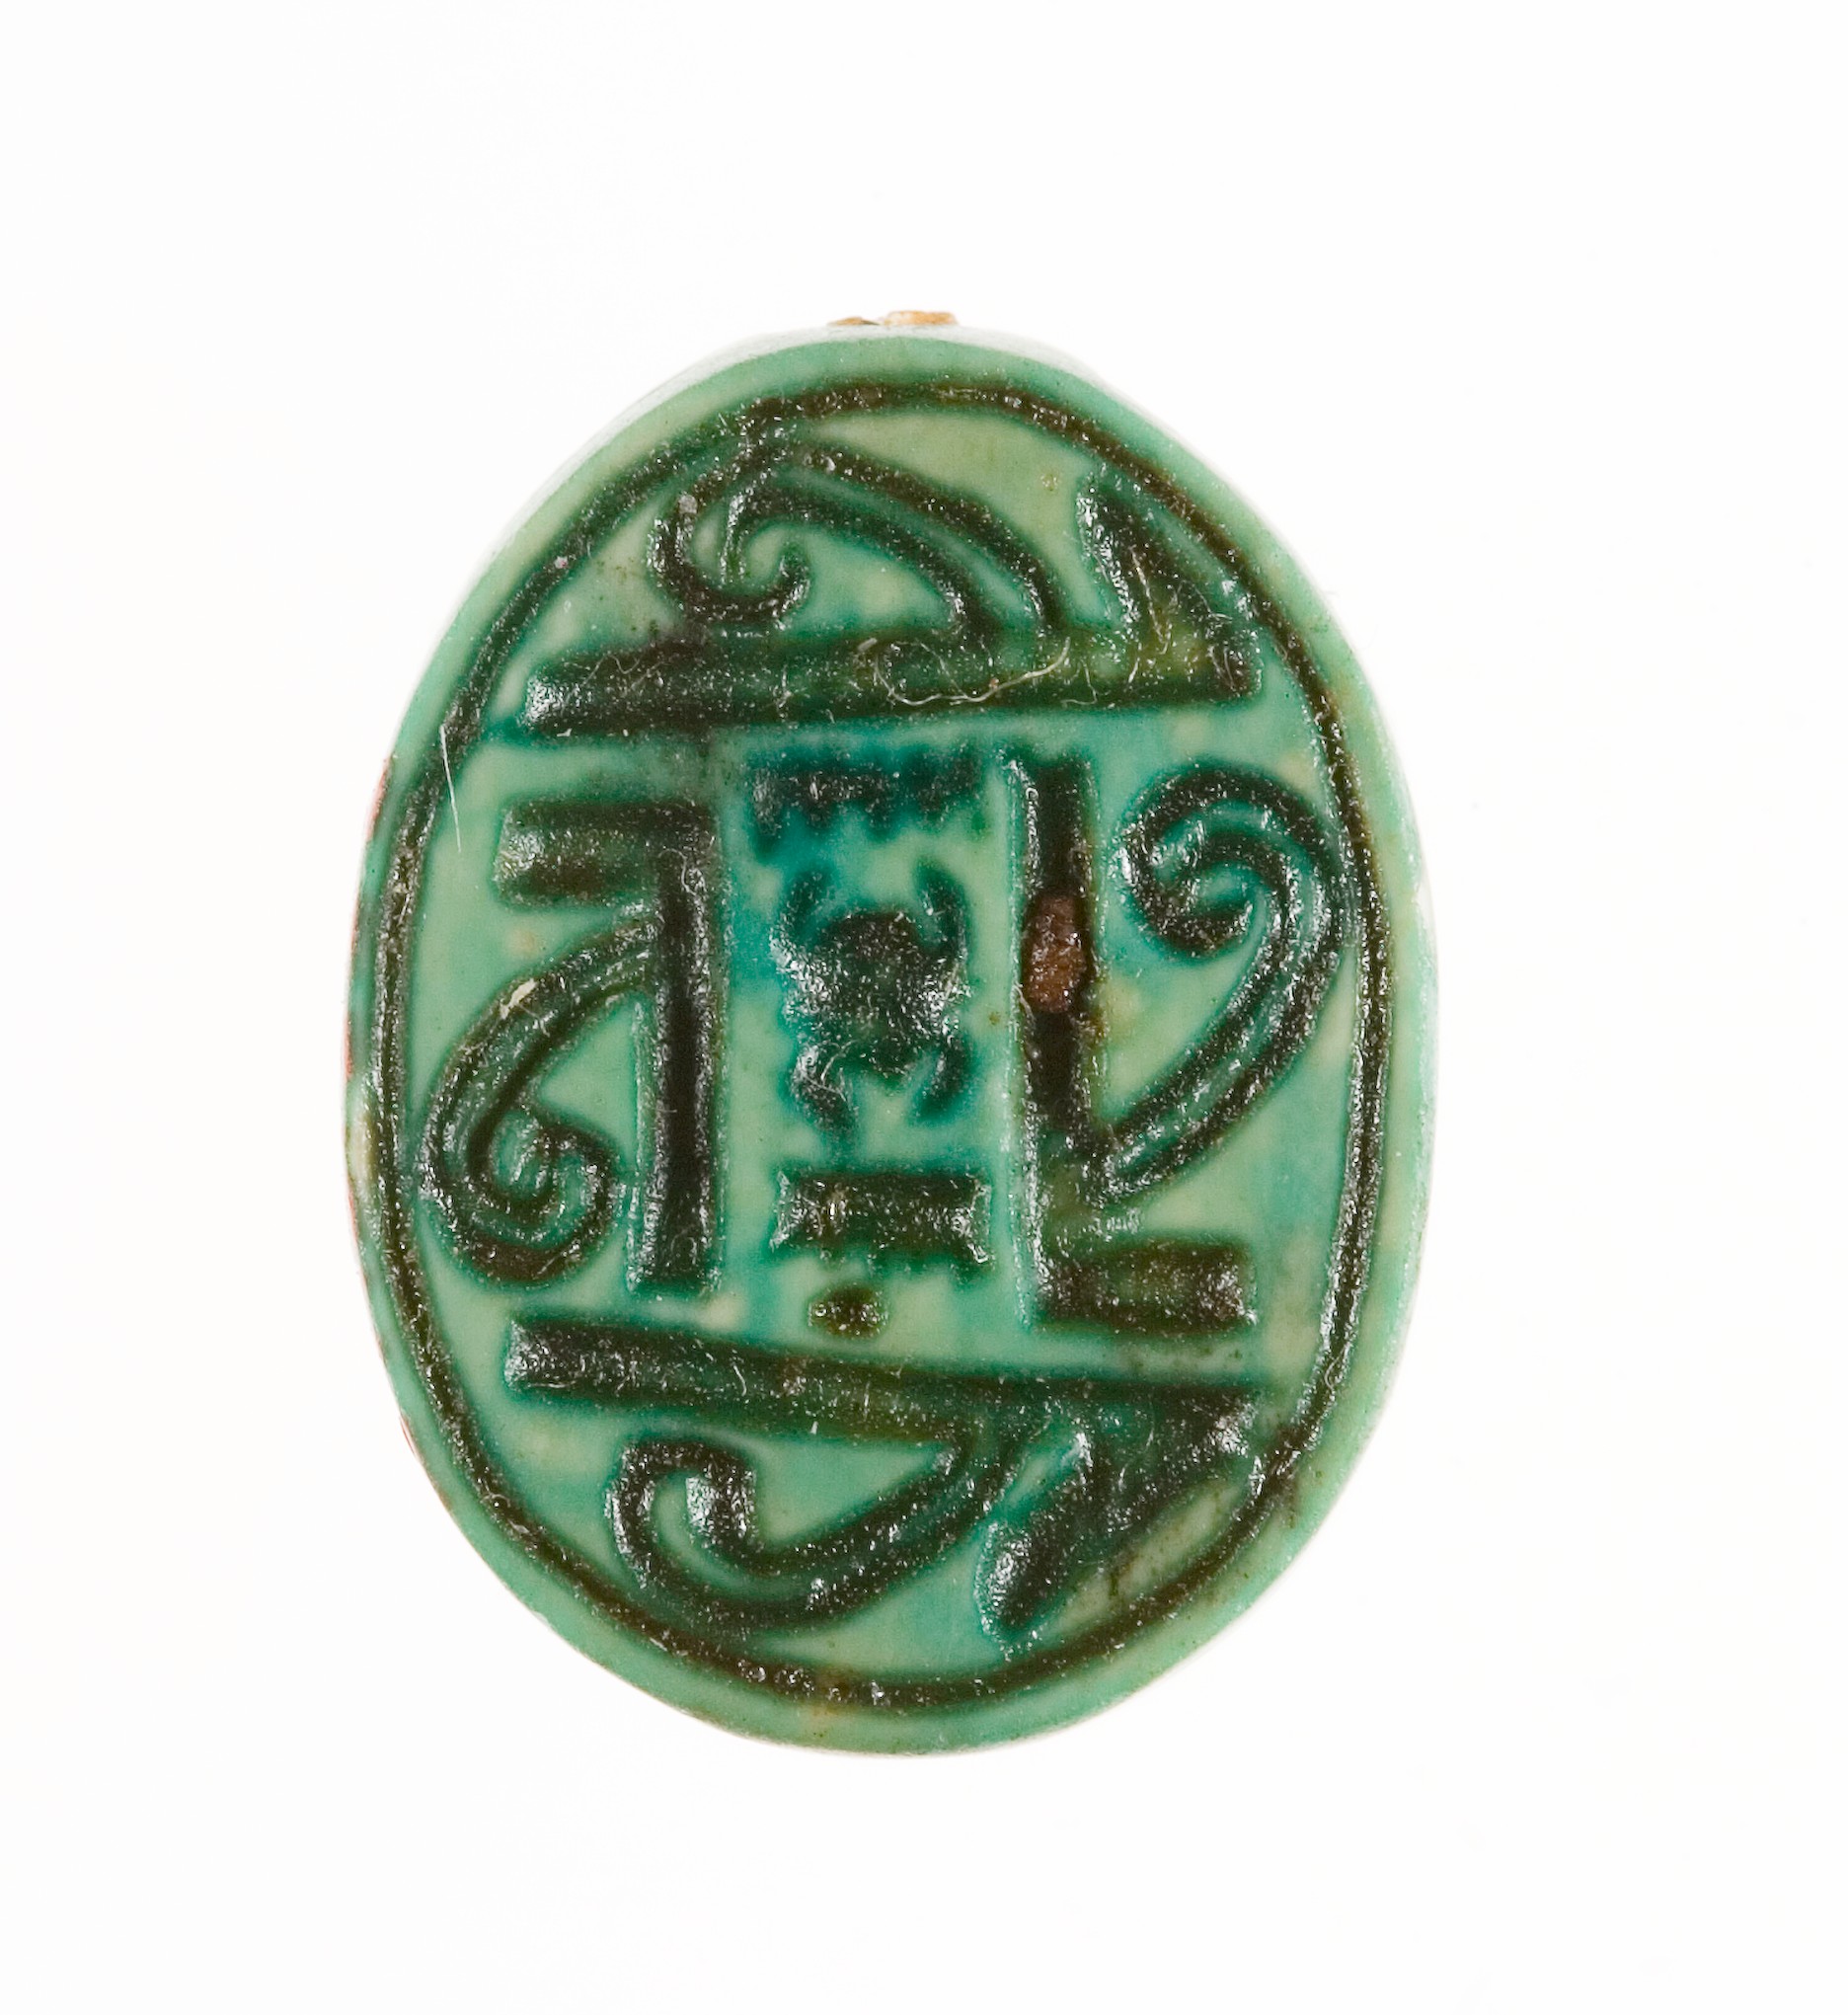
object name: scarab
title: Scarab Inscribed with the Throne Name of Thutmose III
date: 1479-1458 BCE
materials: stone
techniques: glazing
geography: egypt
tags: hieroglyphs,scarabs